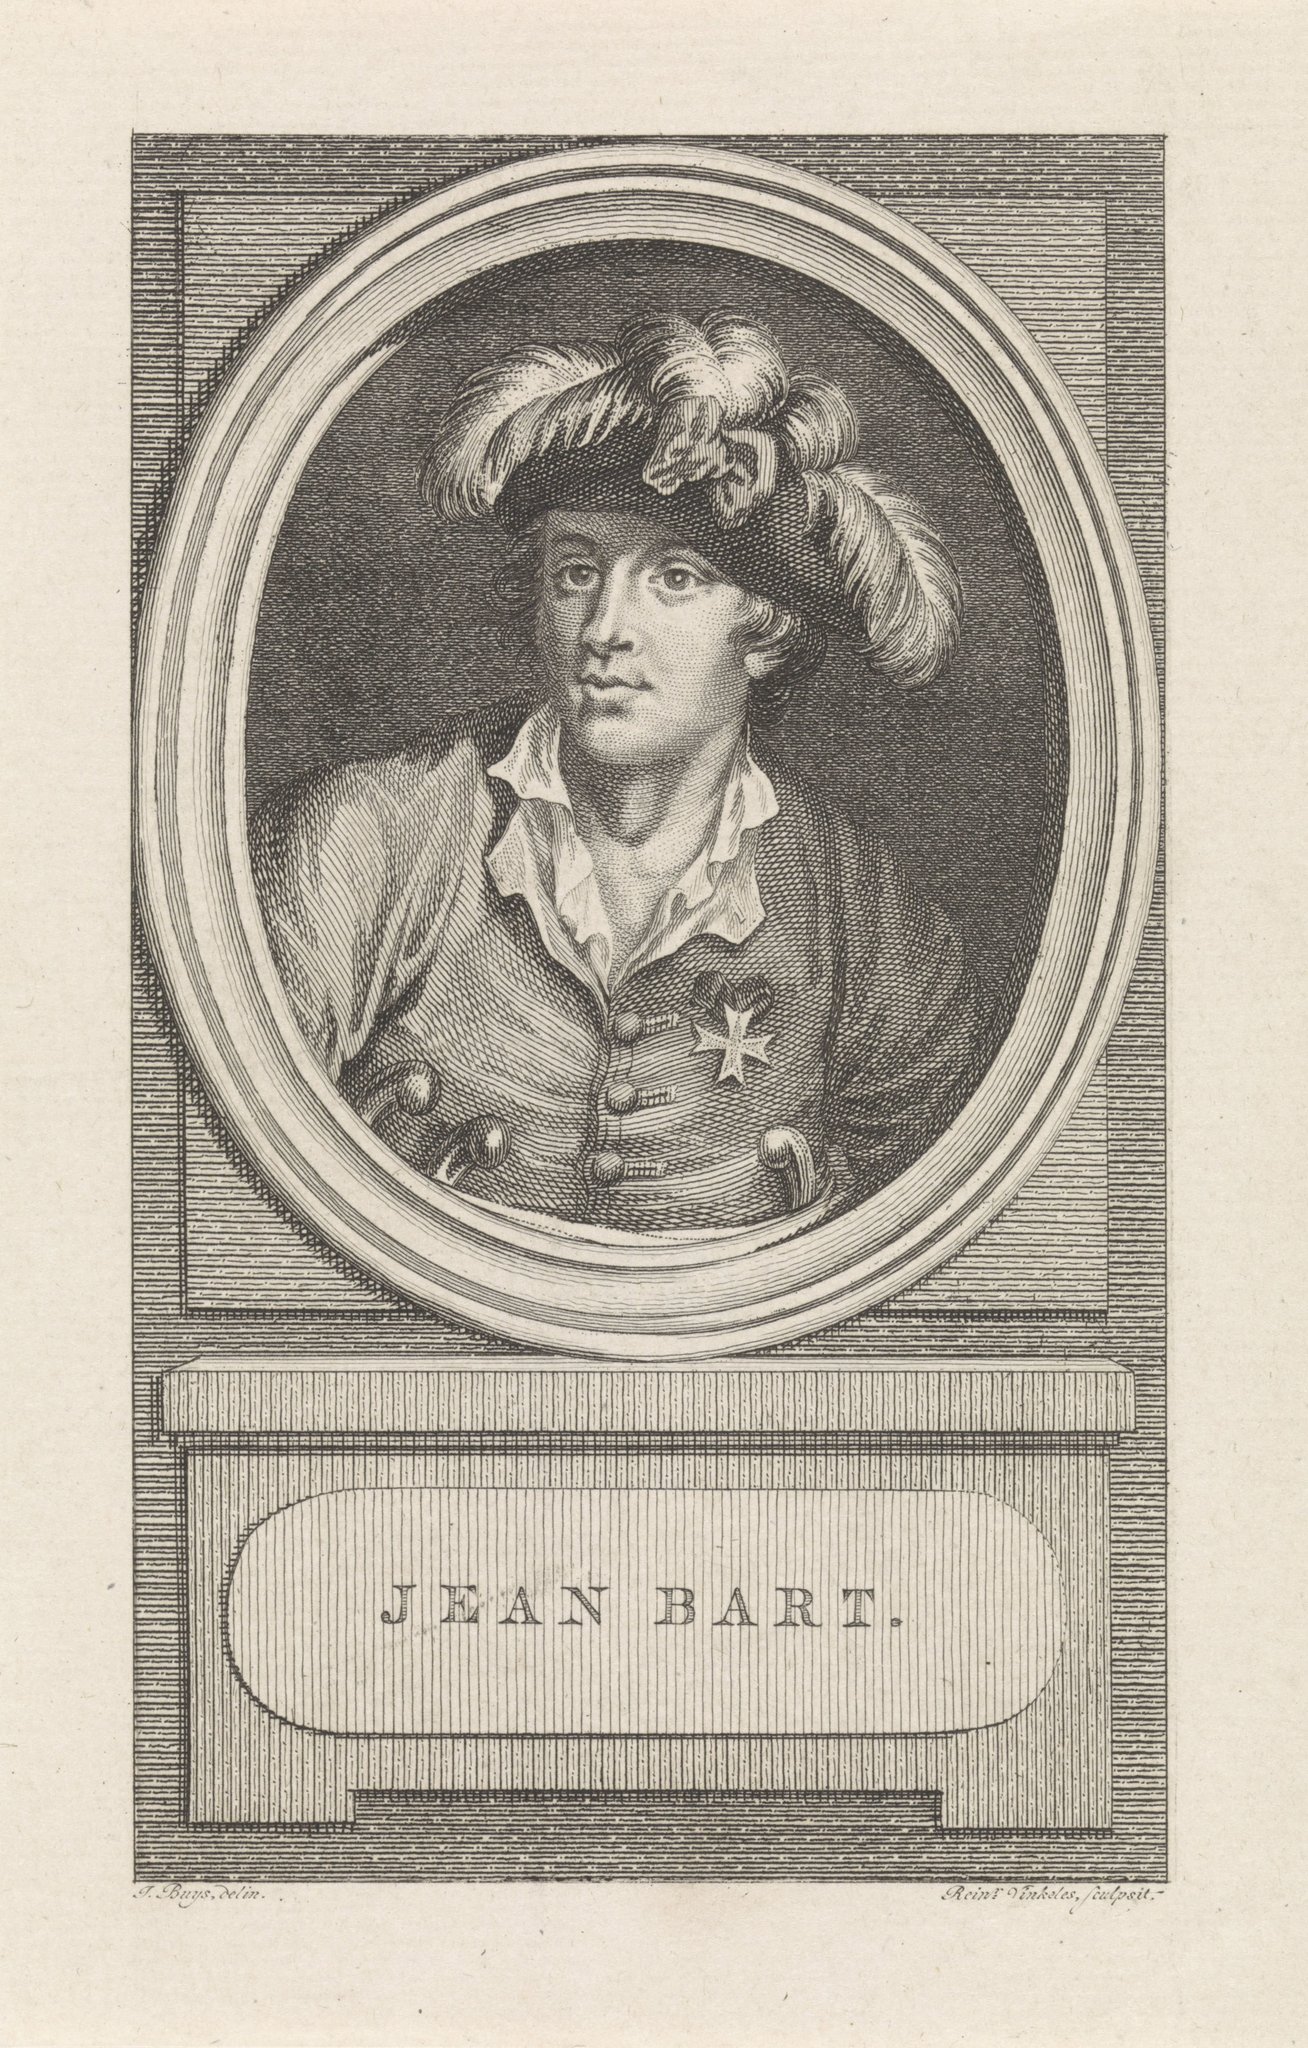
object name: print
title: Portret van Jan Bart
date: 1786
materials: paper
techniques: engraving, etching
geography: amsterdam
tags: duinkerke, kapitein-ter-zee, jan bart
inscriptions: collector's mark: Lugt 2228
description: Latere staat prent gebruikt als boekillustratie in: Kok, Jacobus. Vaderlandsch woordenboek : met kaarten, plaaten en pourtraitten. Amsterdam: Johannes Allart, 1785-1796. Deel V.